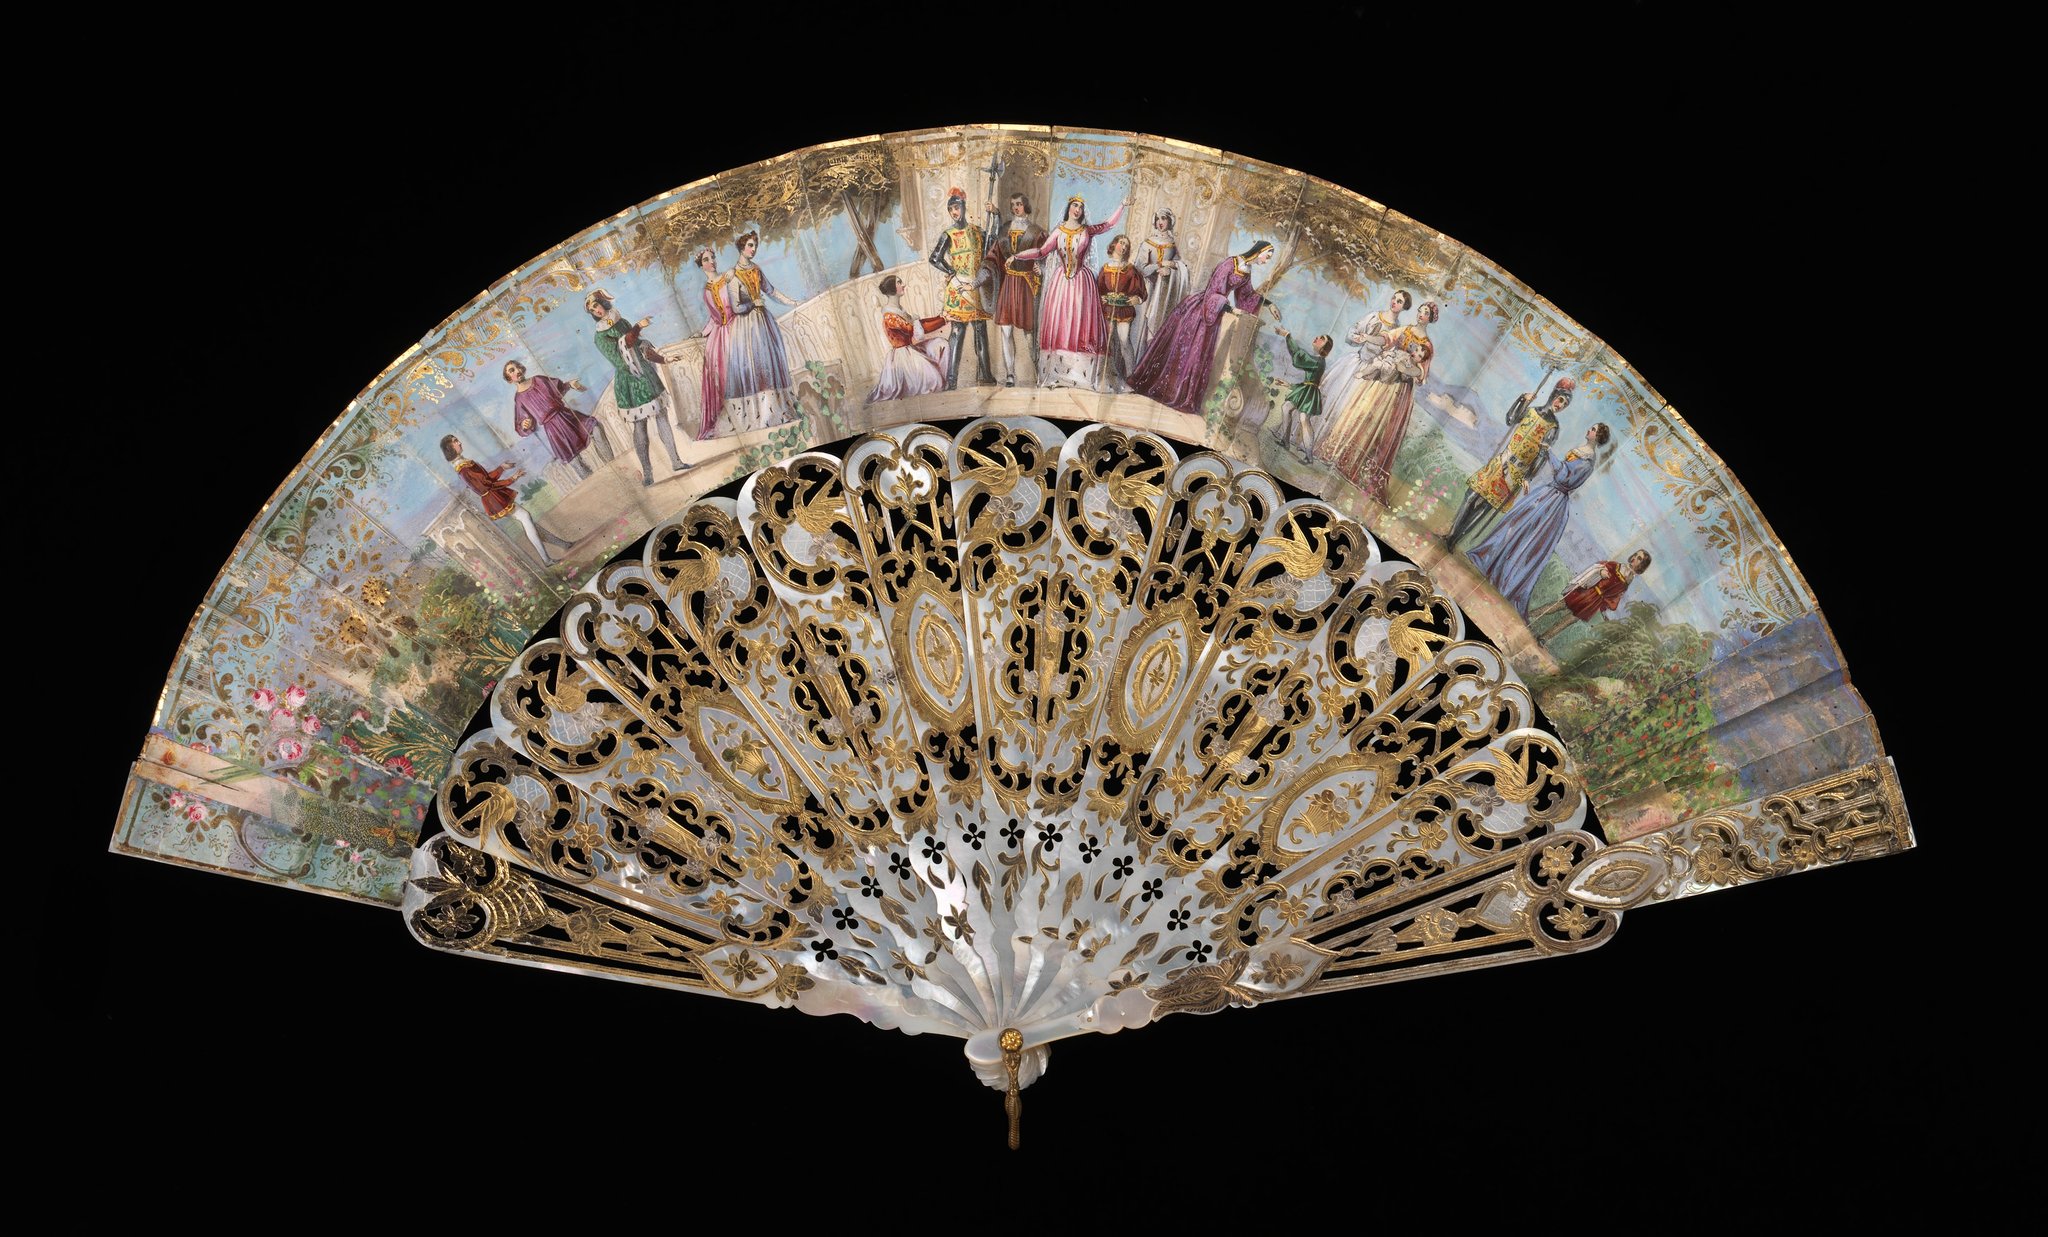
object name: fan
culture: spanish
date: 1855-1865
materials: gouache, metal, mother of pearl, paper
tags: men,women,flowers